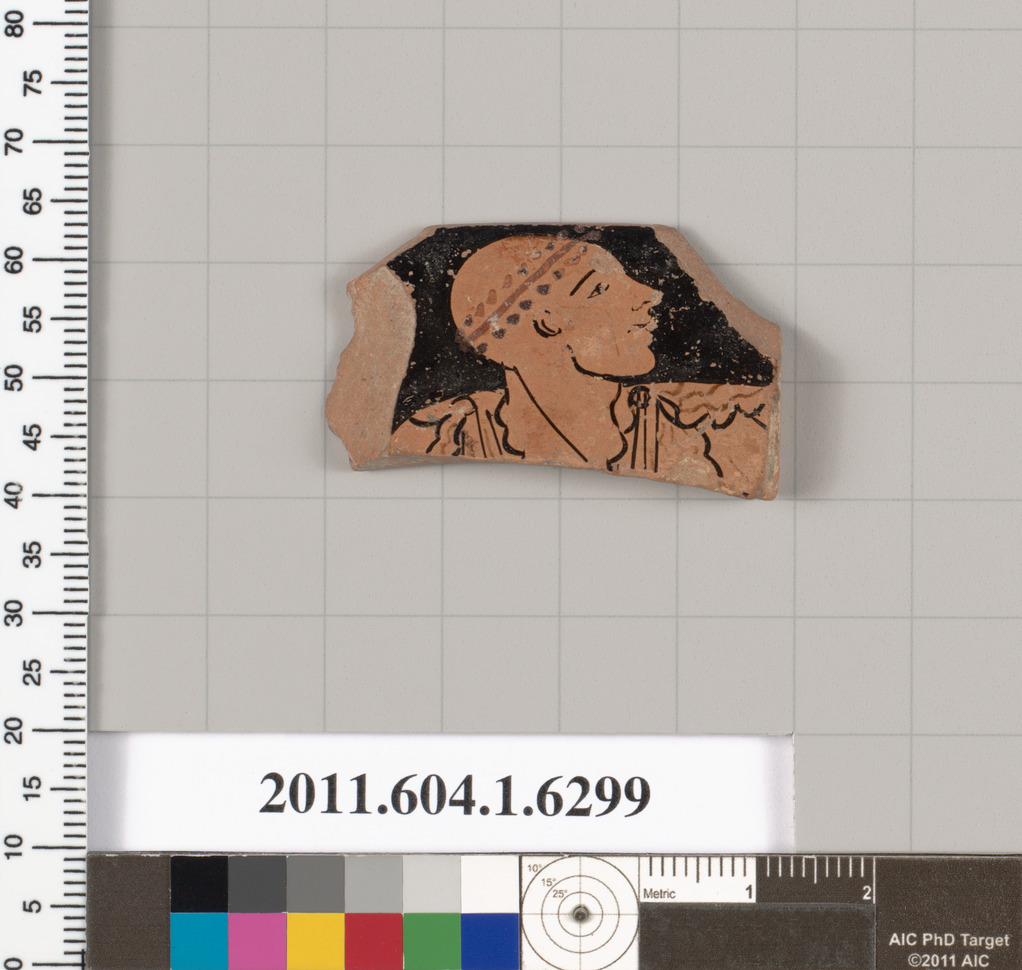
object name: kylix fragment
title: Terracotta rim fragment of a kylix (drinking cup)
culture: greek, attic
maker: eleusis painter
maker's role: artist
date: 500-480 BCE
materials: terracotta